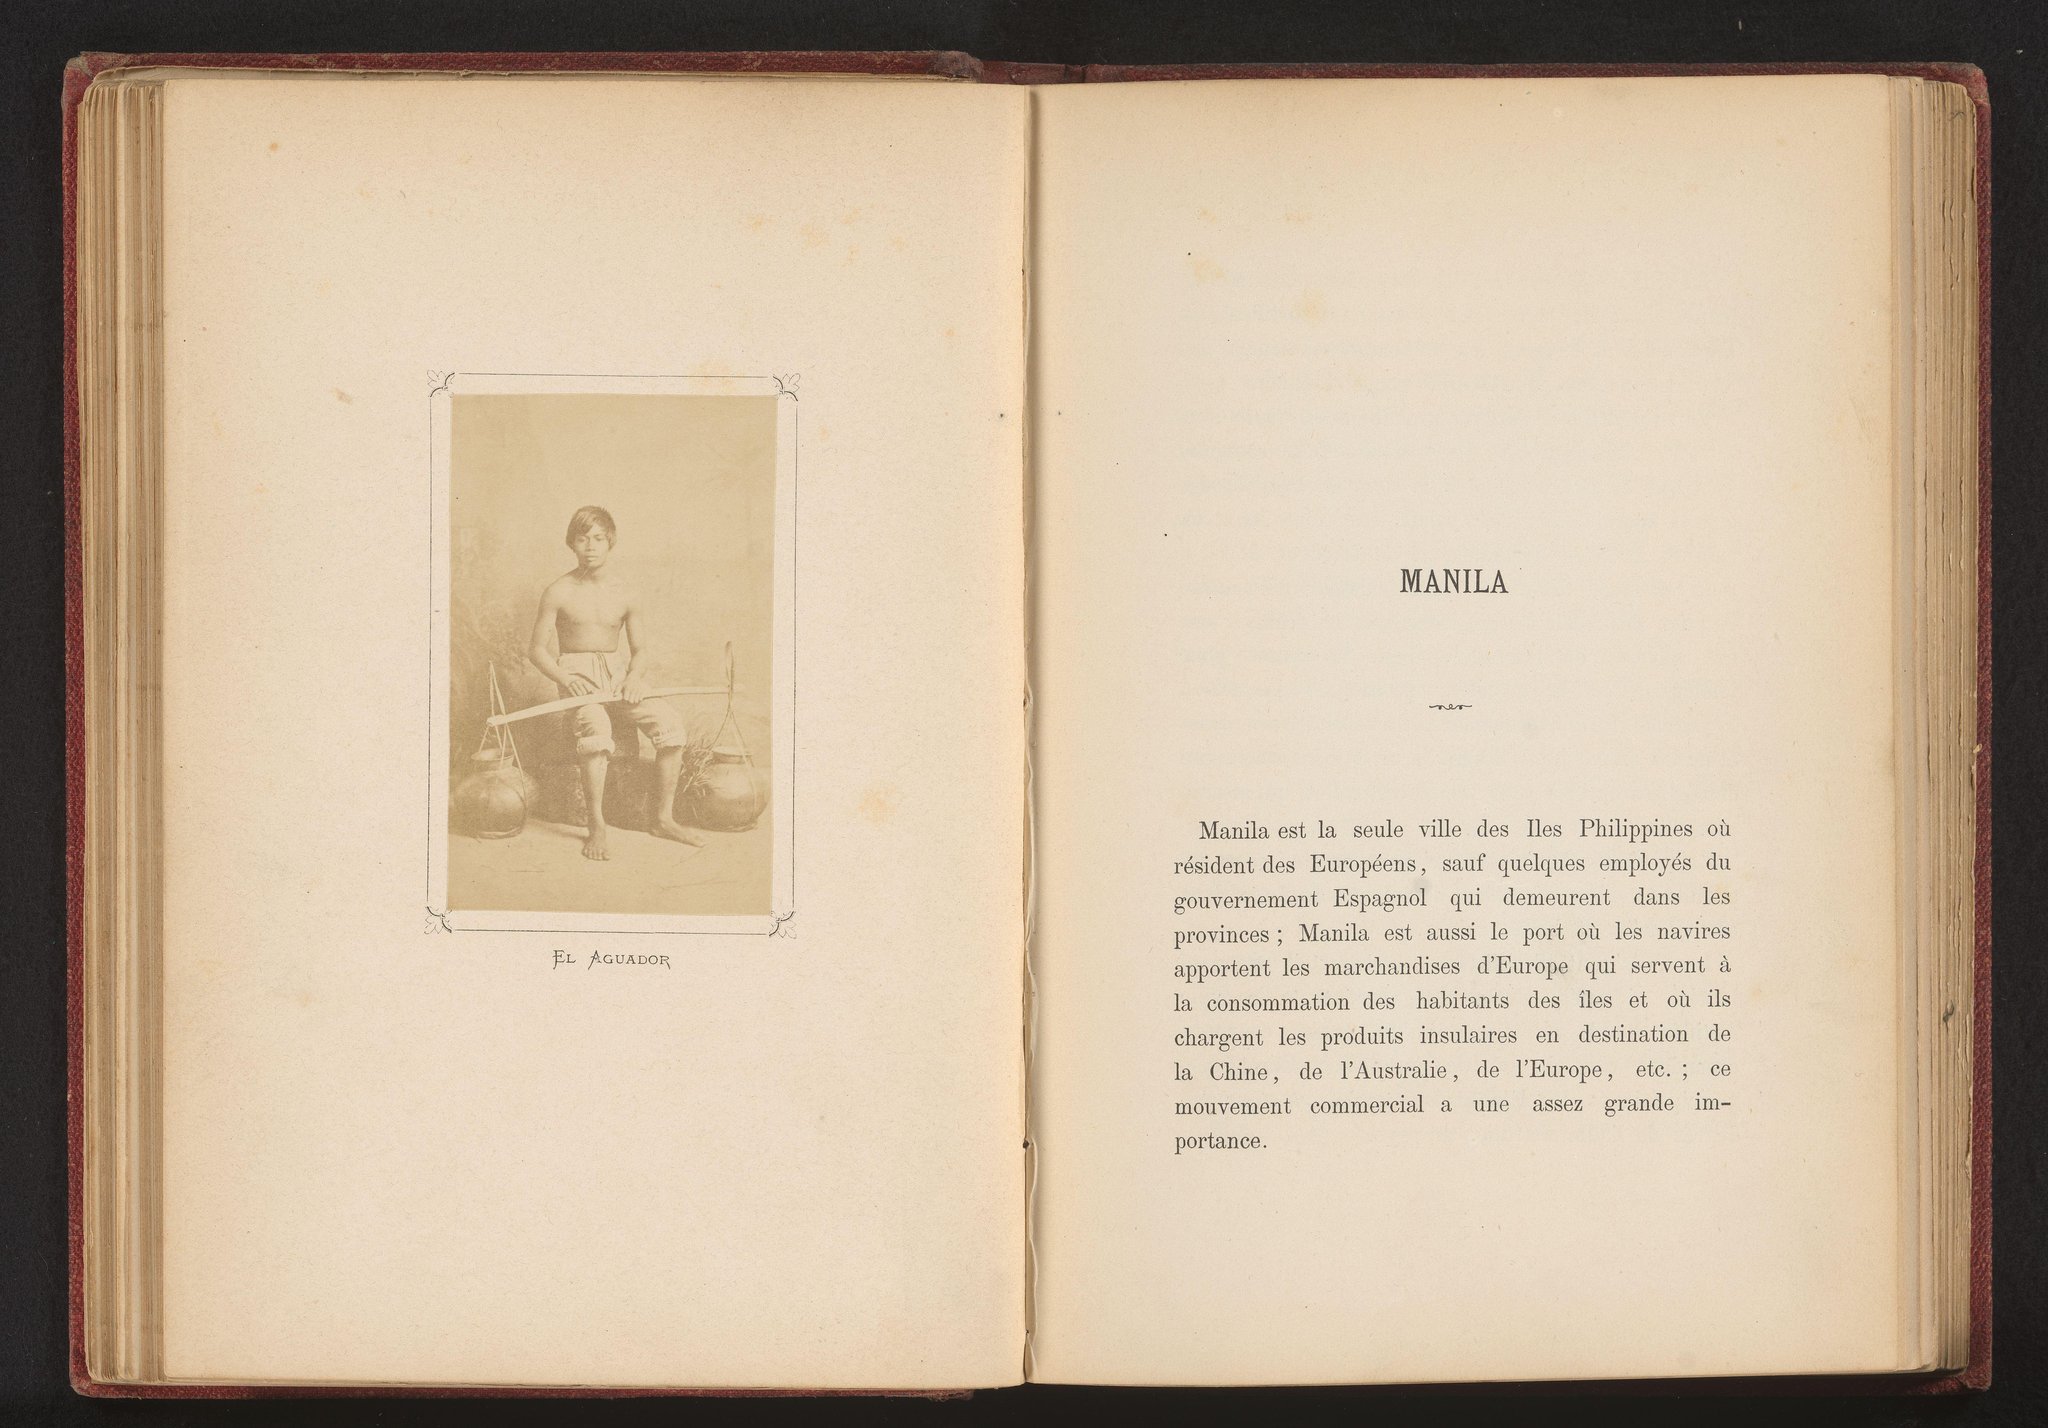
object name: page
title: El Aguador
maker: Anonymous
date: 1865-1875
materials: paper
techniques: albumen print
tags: boy (child between toddler and youth), historical persons, container of ceramics: jar, jug, pot, vase